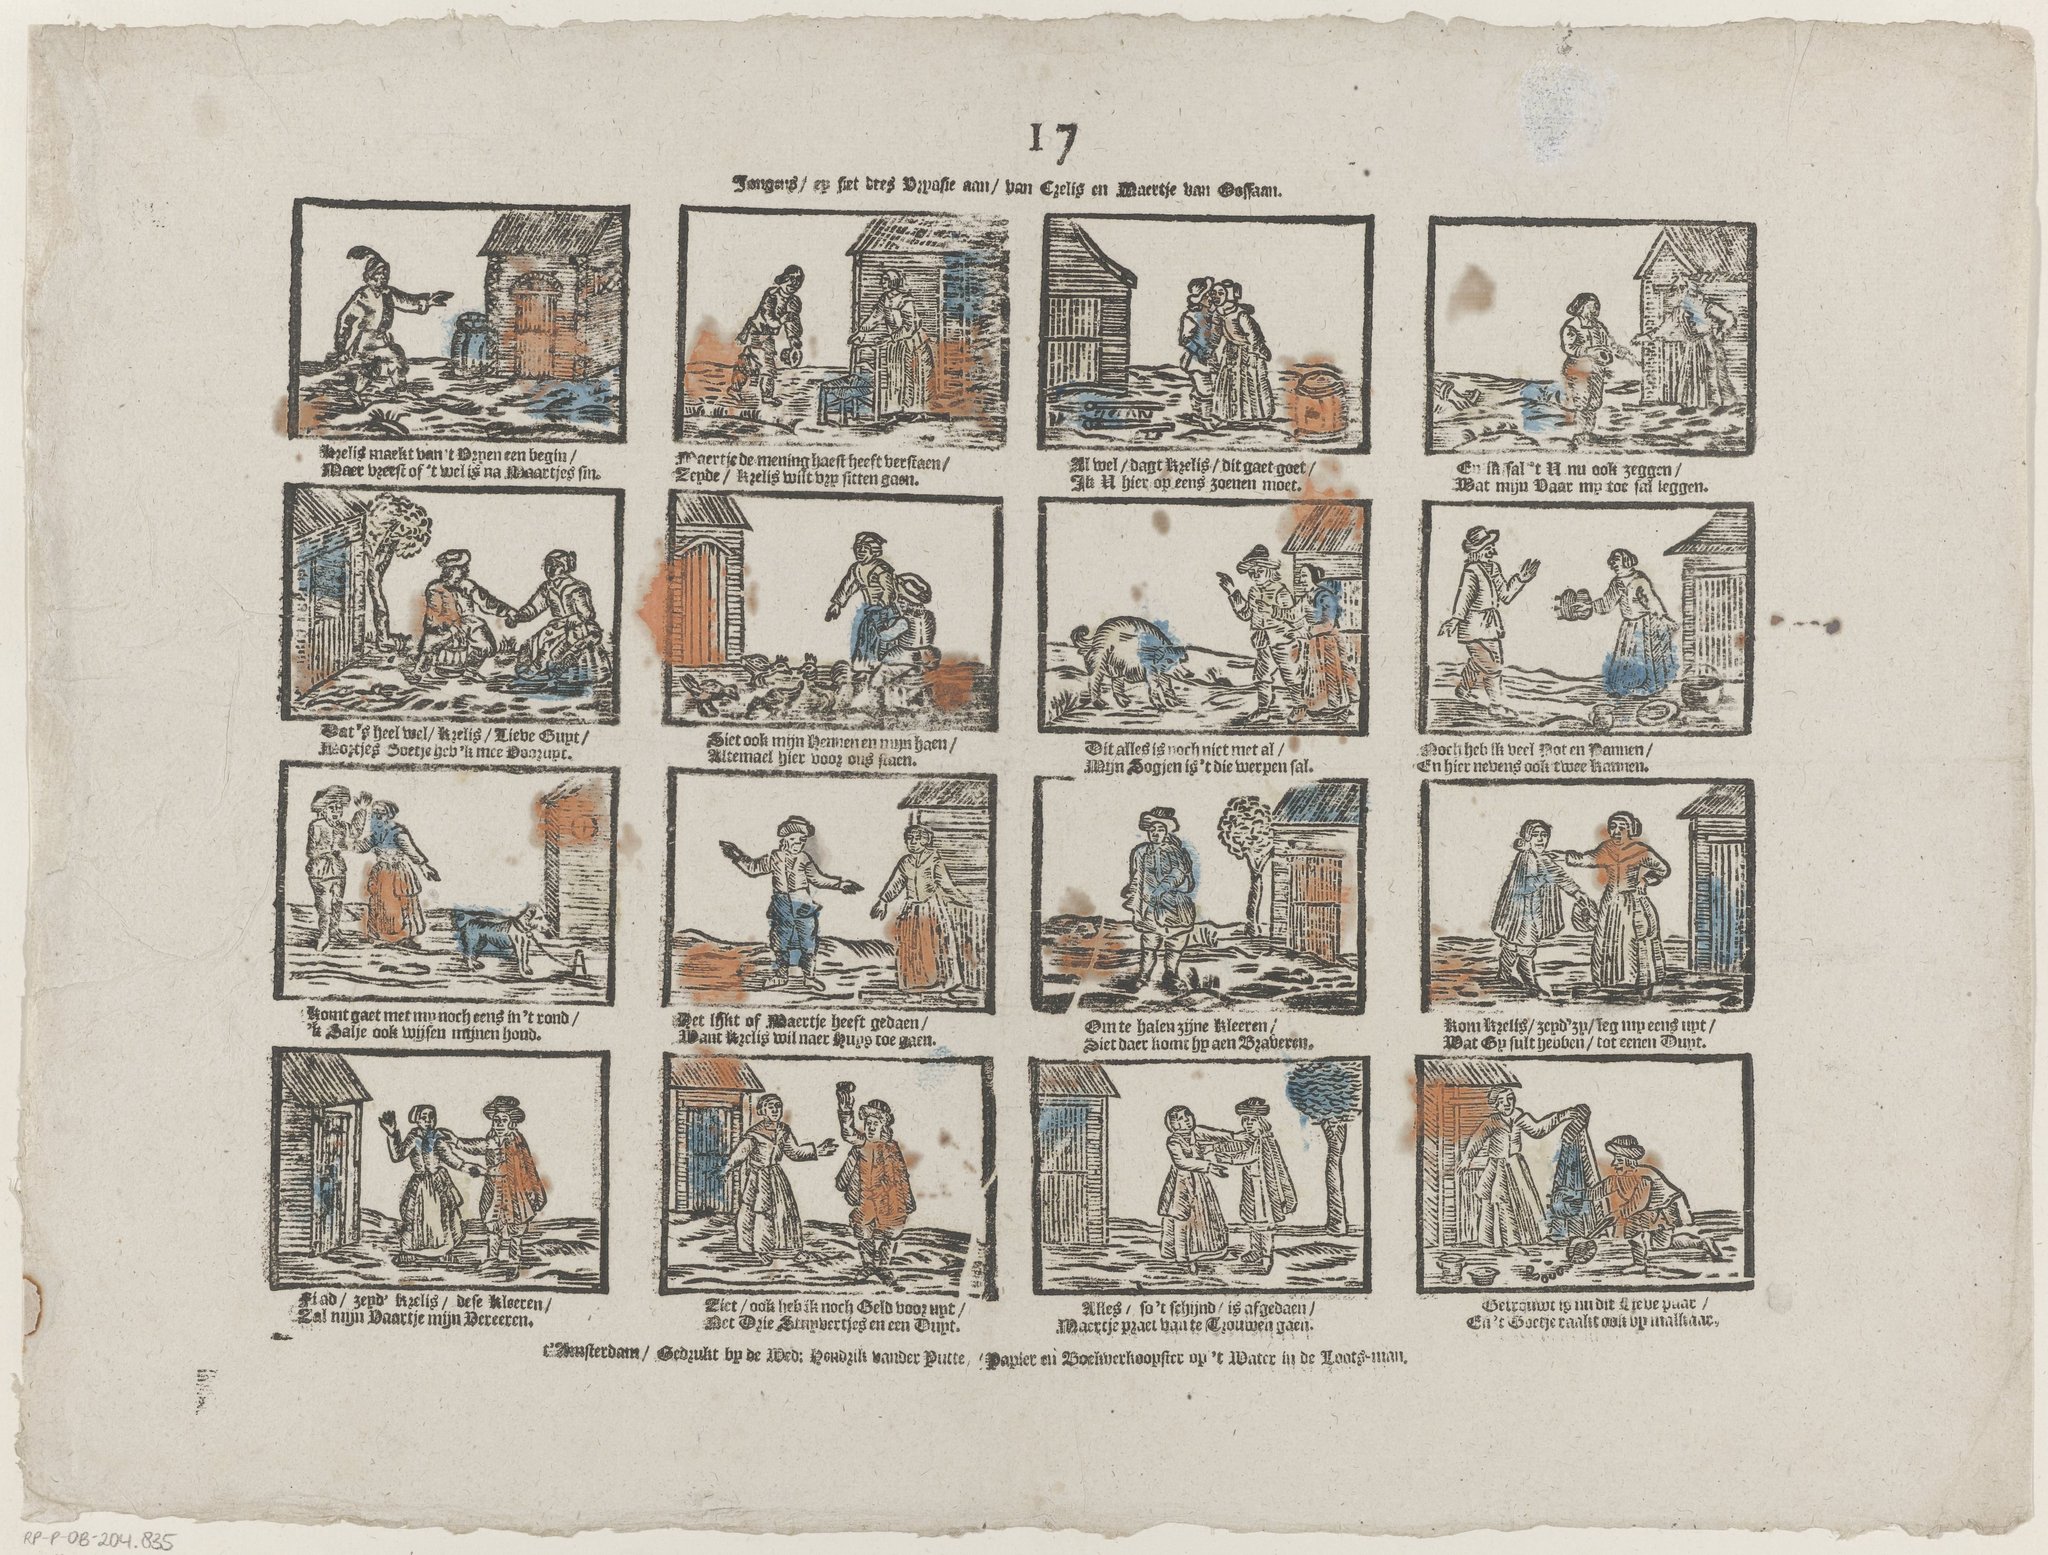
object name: popular print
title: Jongens / ey siet dees vryasie aan / van Crelis en Maertje van Ossaan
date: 1765-1767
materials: paper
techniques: colour, letterpress printing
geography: amsterdam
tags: courting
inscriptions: collector's mark: Lugt 2760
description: Blad met 16 voorstellingen van de vrijage van de arme Krelis en Maartje van Oostzaan. Onder elke afbeelding een tweeregelig vers. Genummerd midden boven: 17.